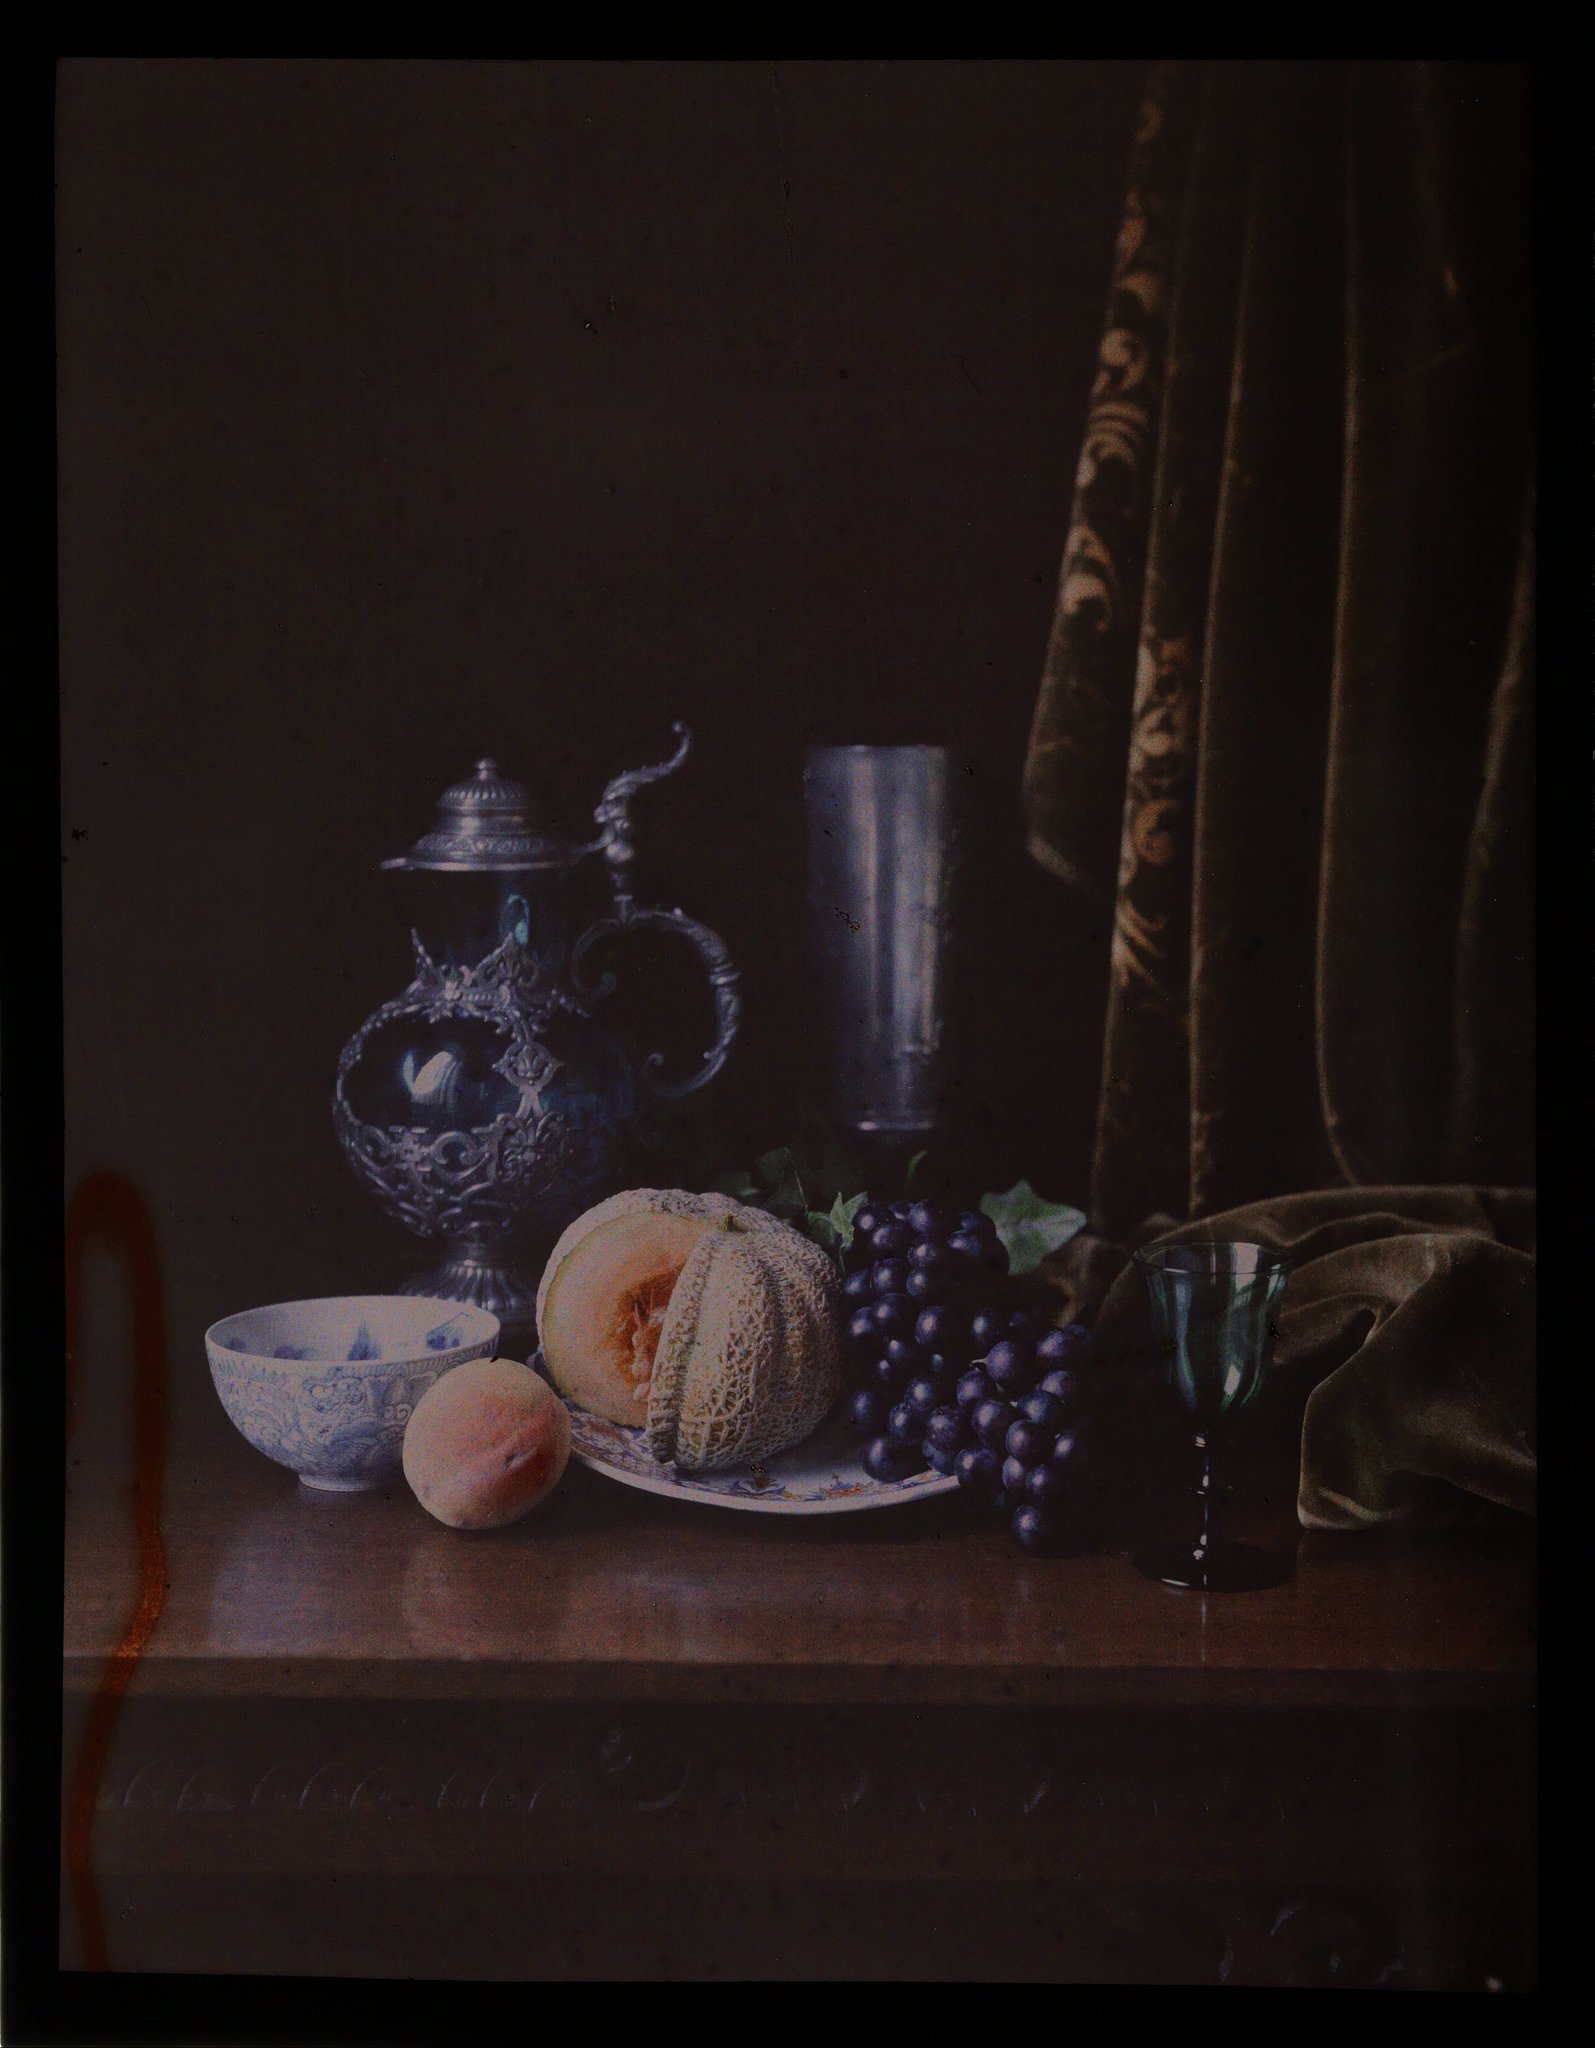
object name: photograph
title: Stilleven met fruit, kan en glazen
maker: Anonymous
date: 1907-1935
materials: glass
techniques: autochrome process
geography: netherlands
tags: still life of miscellaneous objects, netherlands